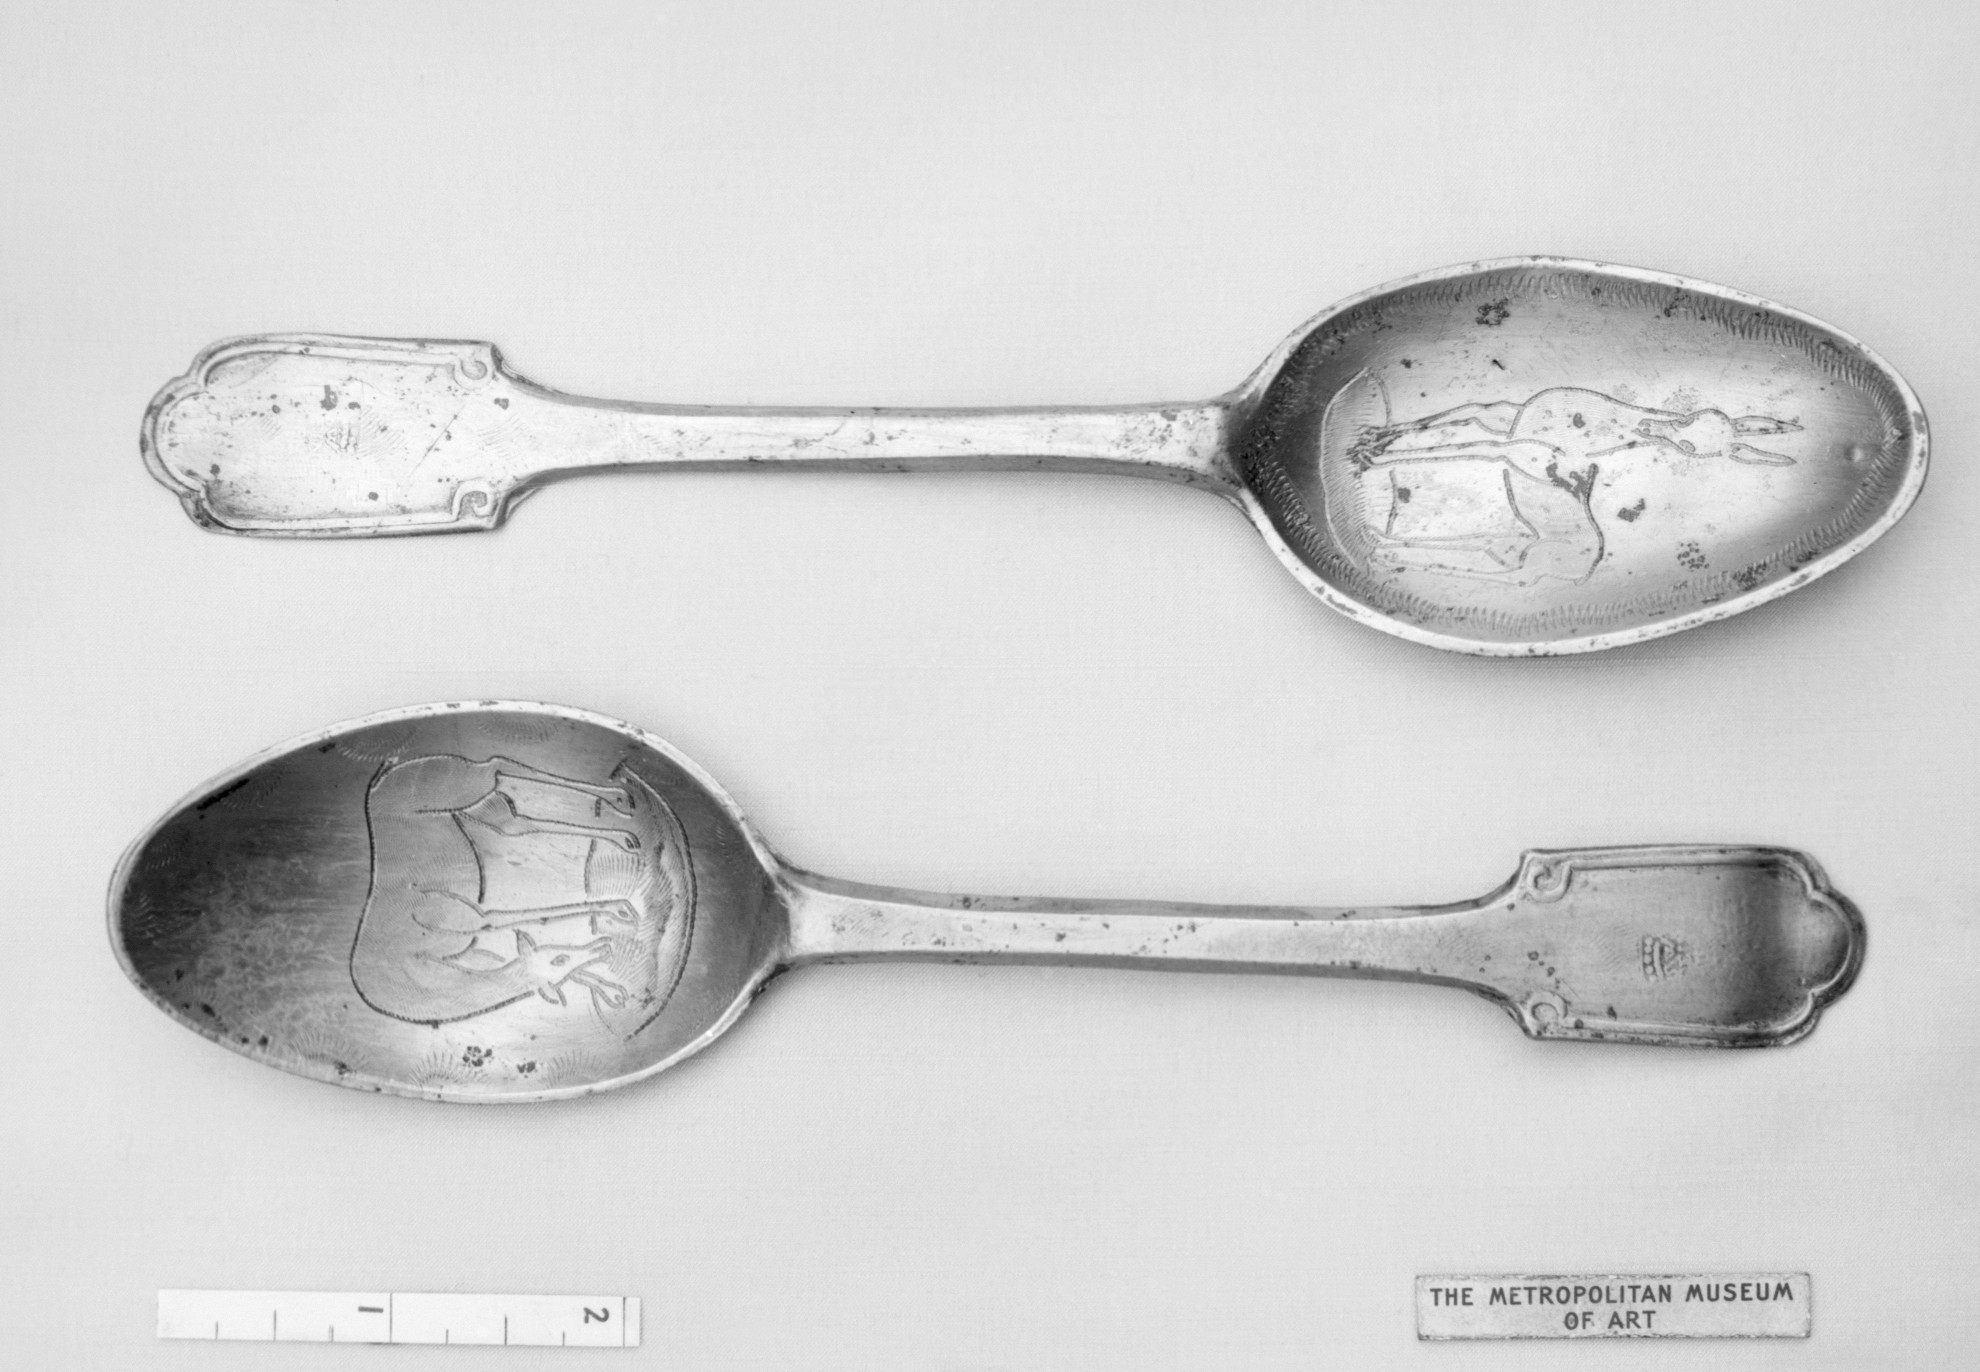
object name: spoon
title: Pair of spoons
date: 1734-1766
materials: pewter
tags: animals